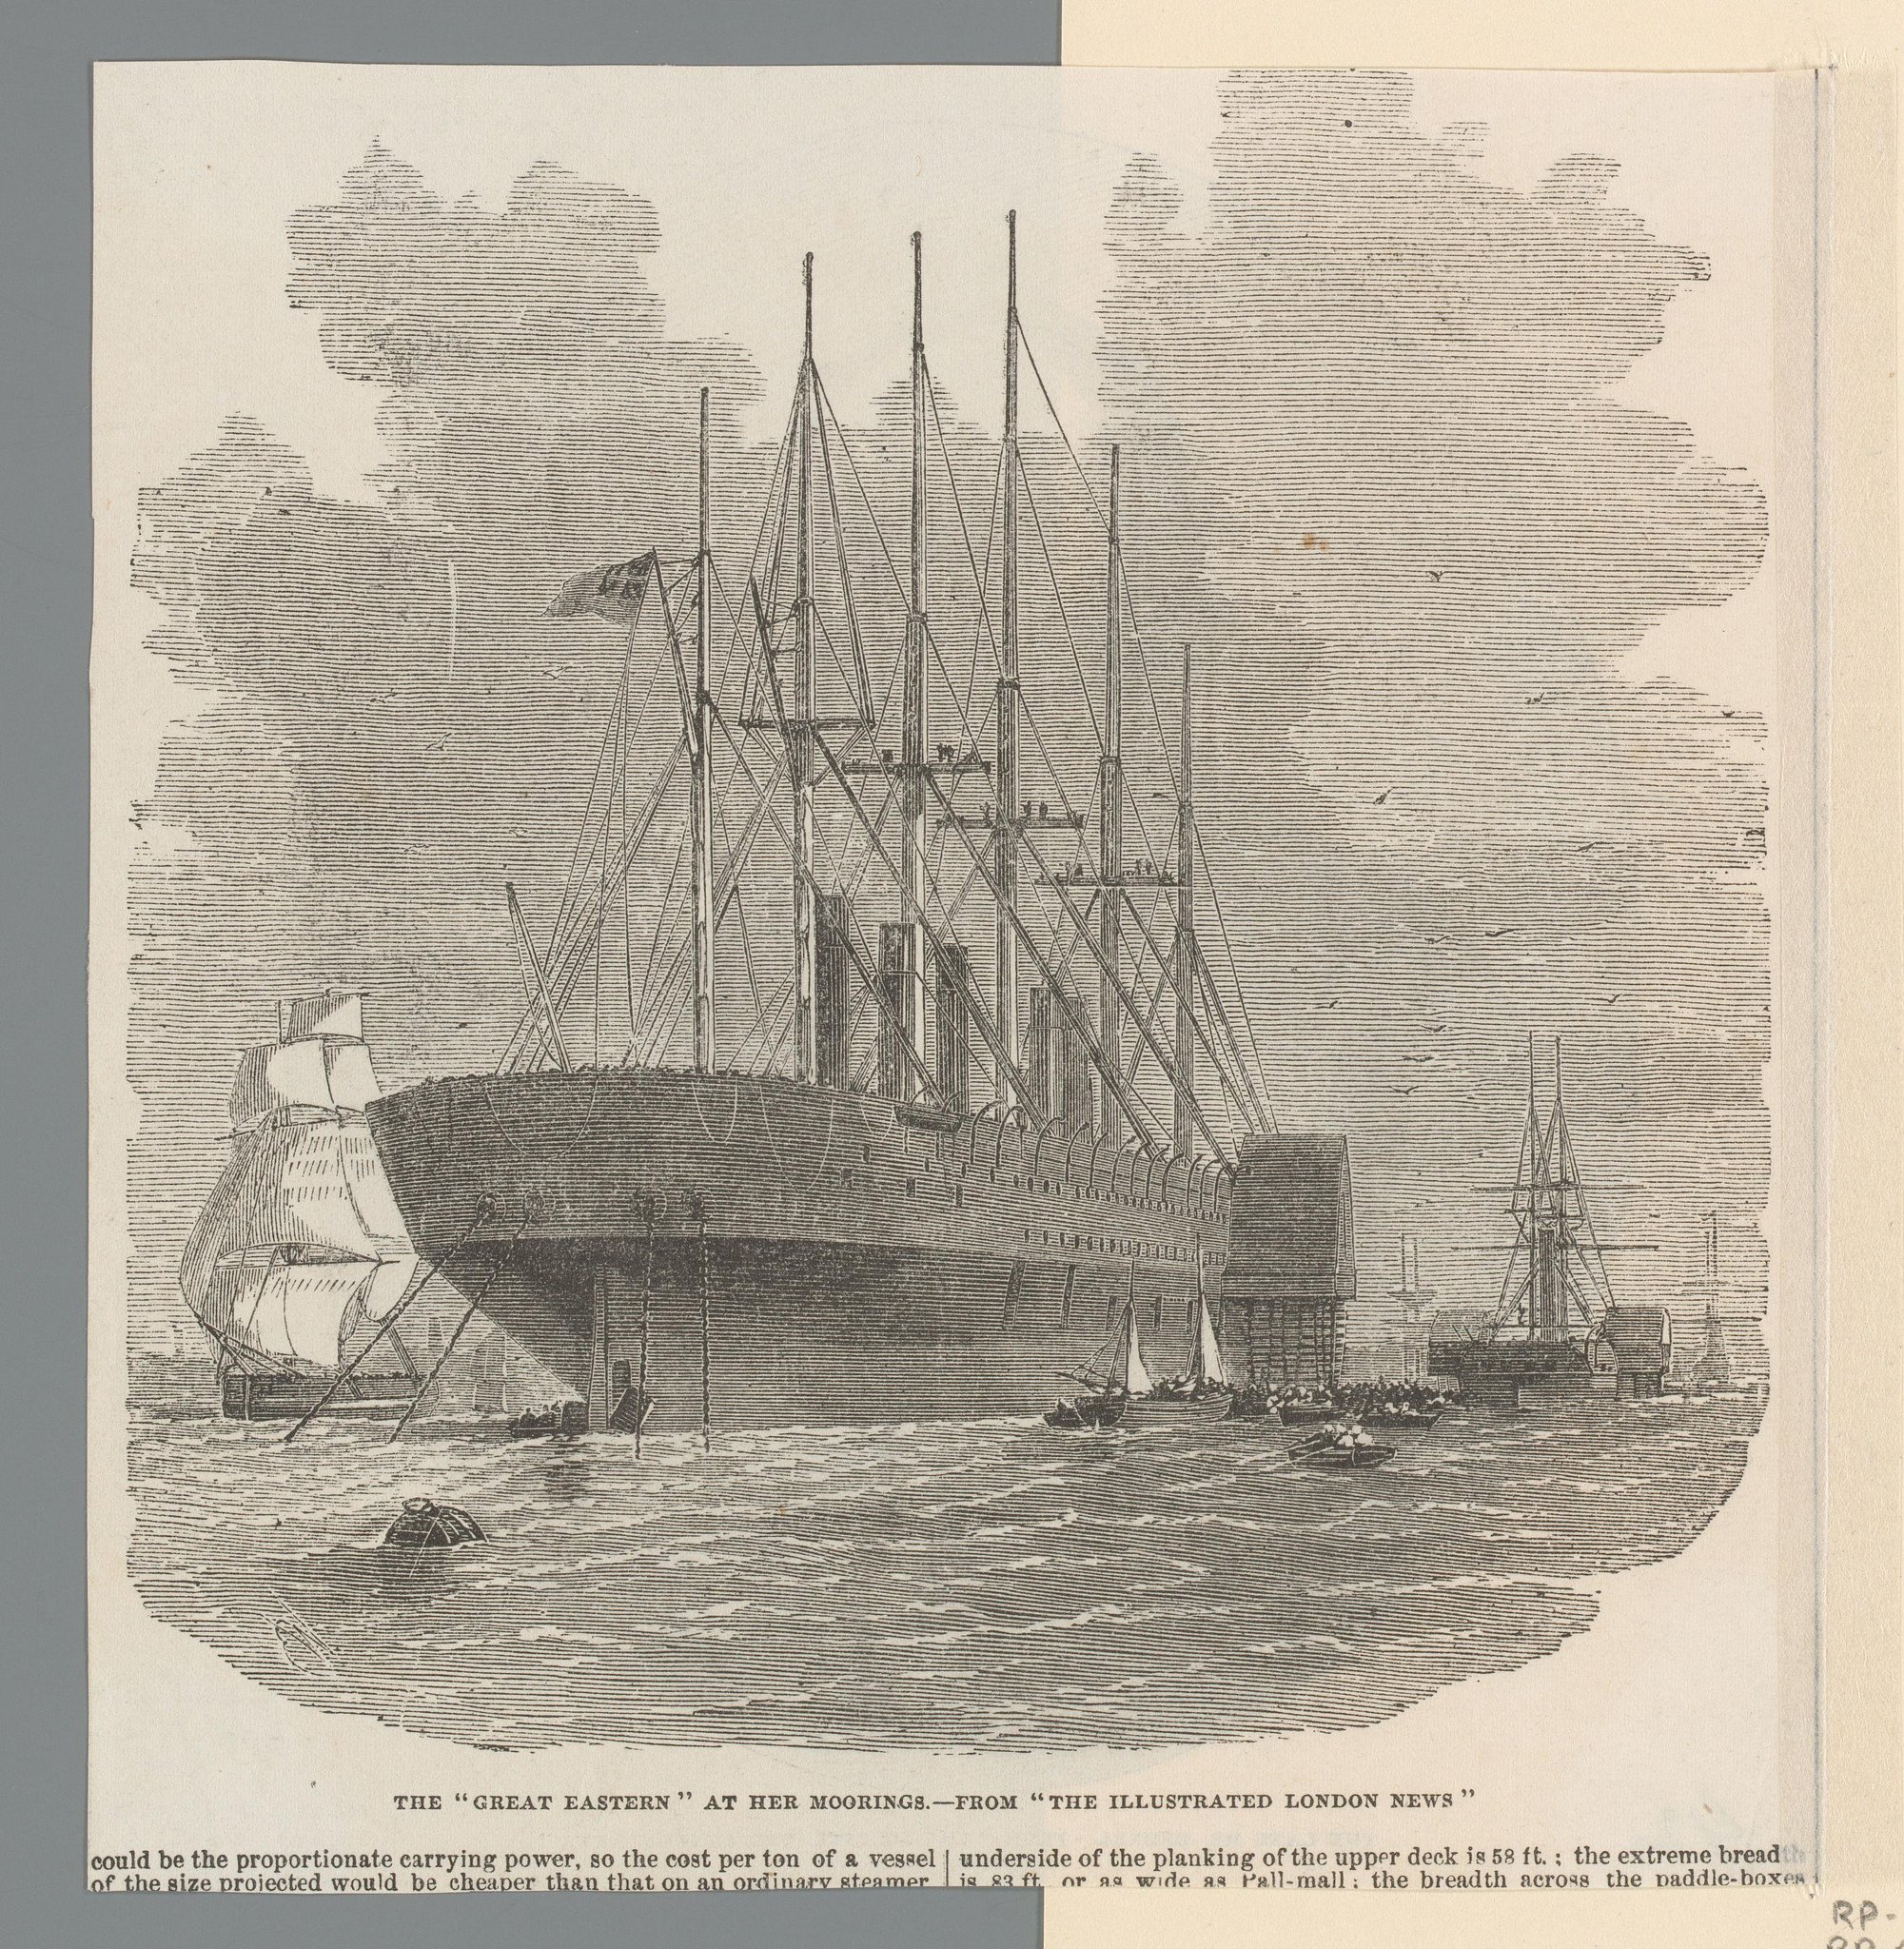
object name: print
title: Stoomschip Great Eastern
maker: Anonymous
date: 1860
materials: paper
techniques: letterpress printing, engraving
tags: steamship, motorship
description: Prent uit: The Illustrated London Almanach for 1860.